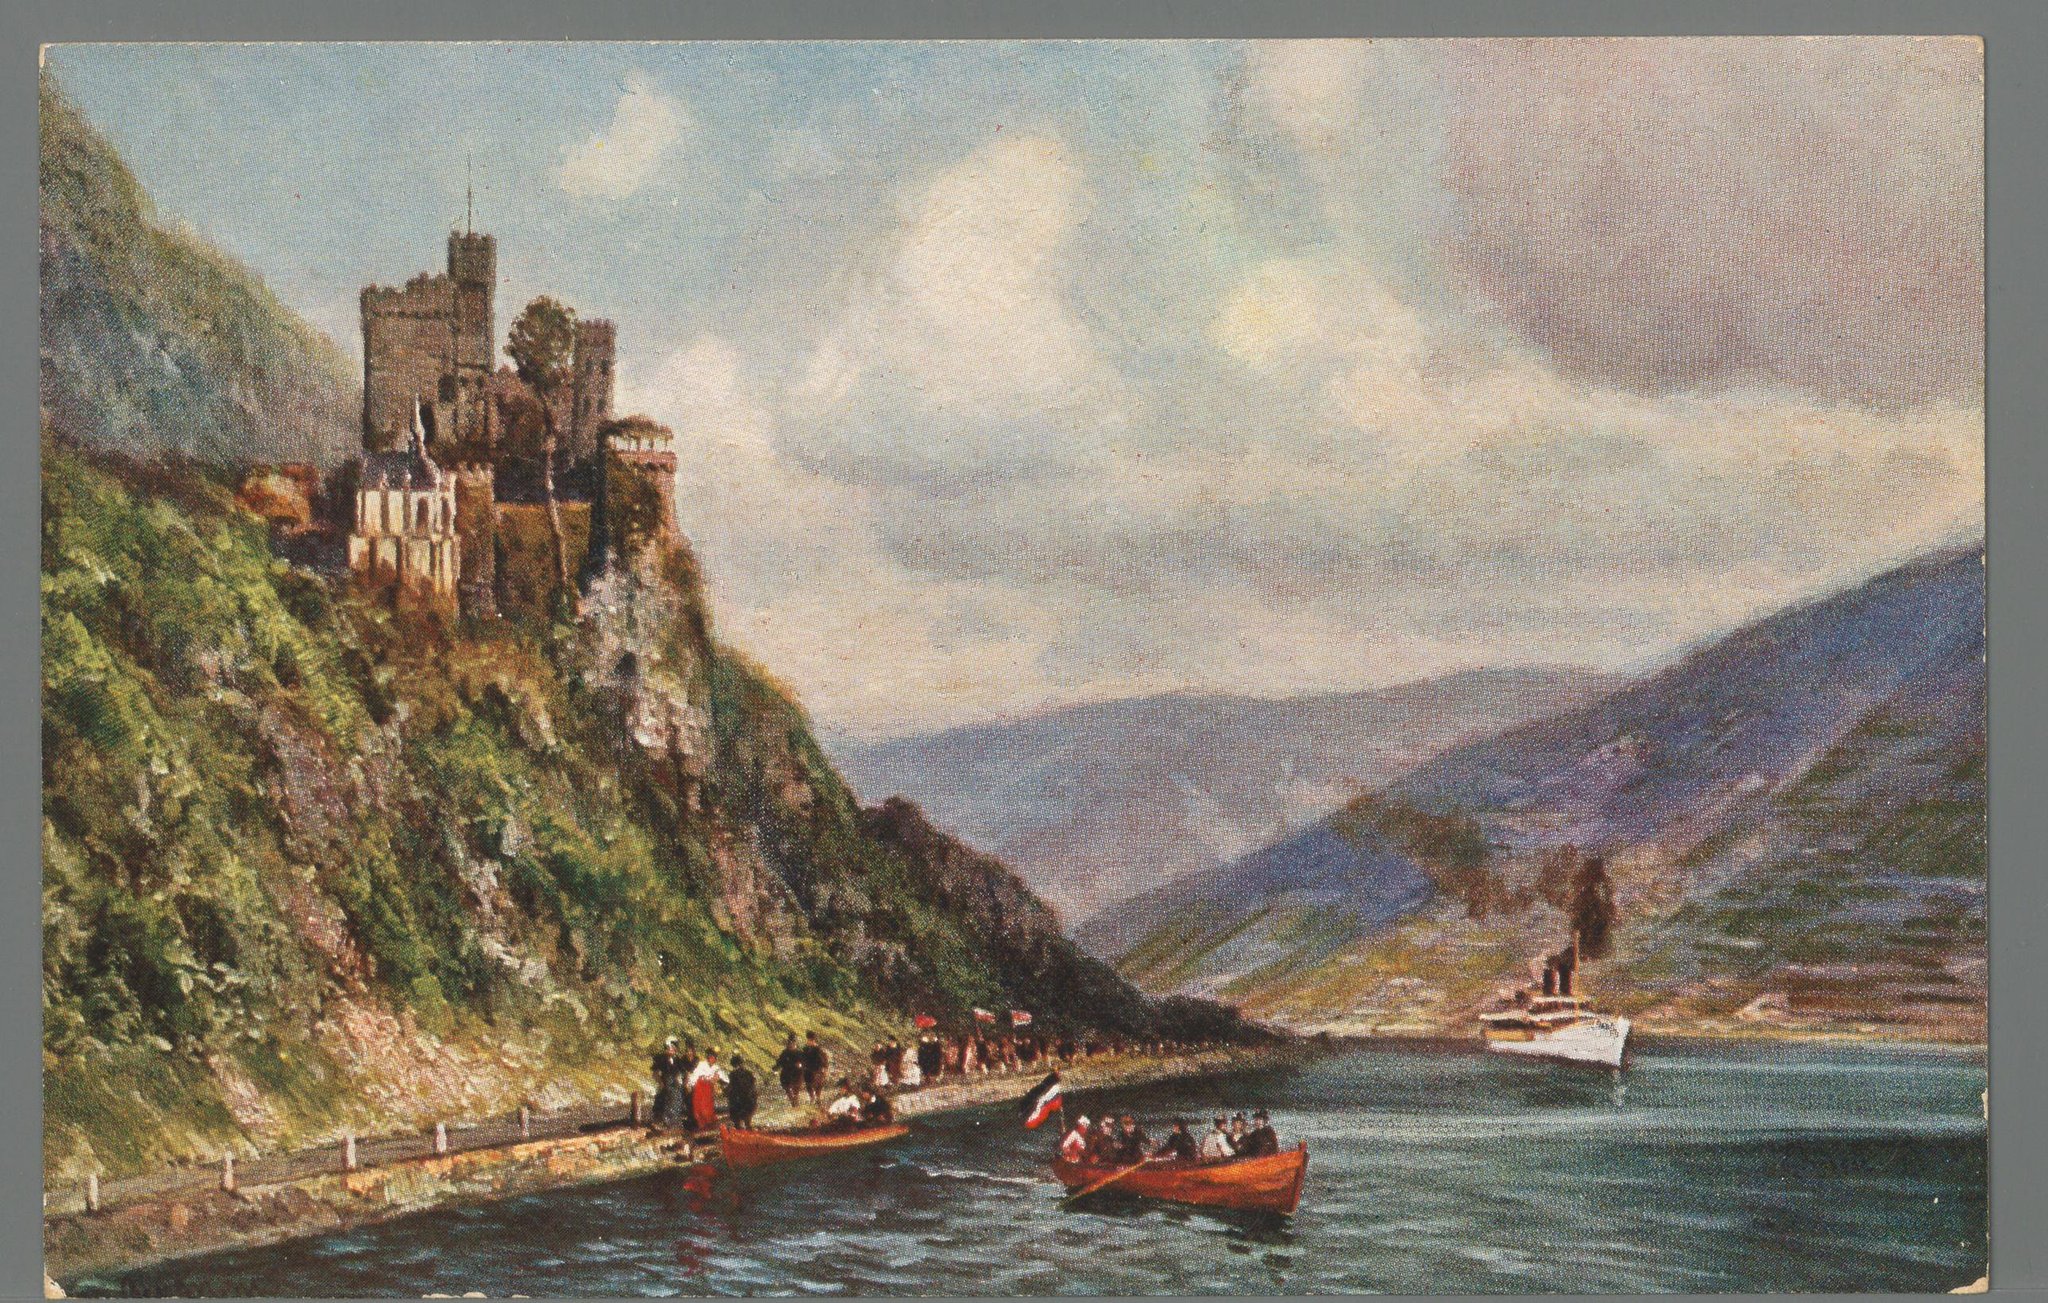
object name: ansichtkaart, prentbriefkaart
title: T.S.N. Serie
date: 1905-1930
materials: cardboard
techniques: color autotype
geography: nuremberg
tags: castle, river